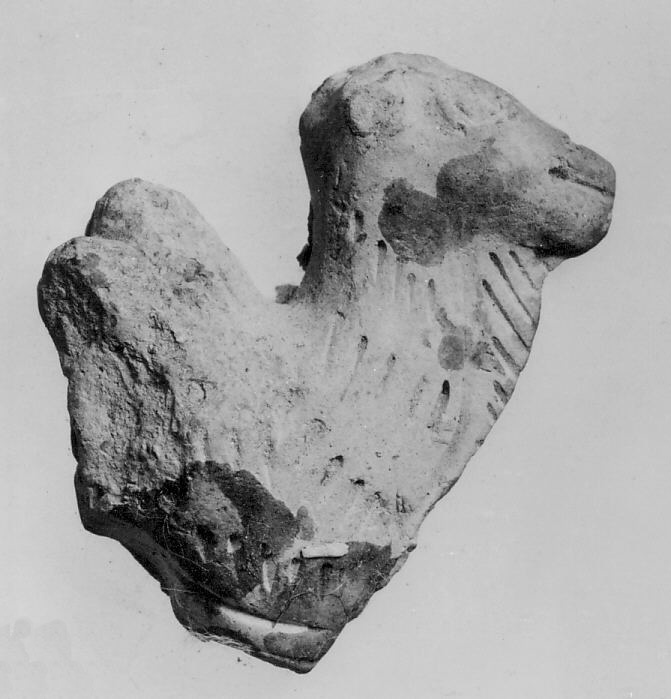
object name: figurine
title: Head of a Camel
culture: central asian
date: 1101-1133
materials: earthenware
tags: camels